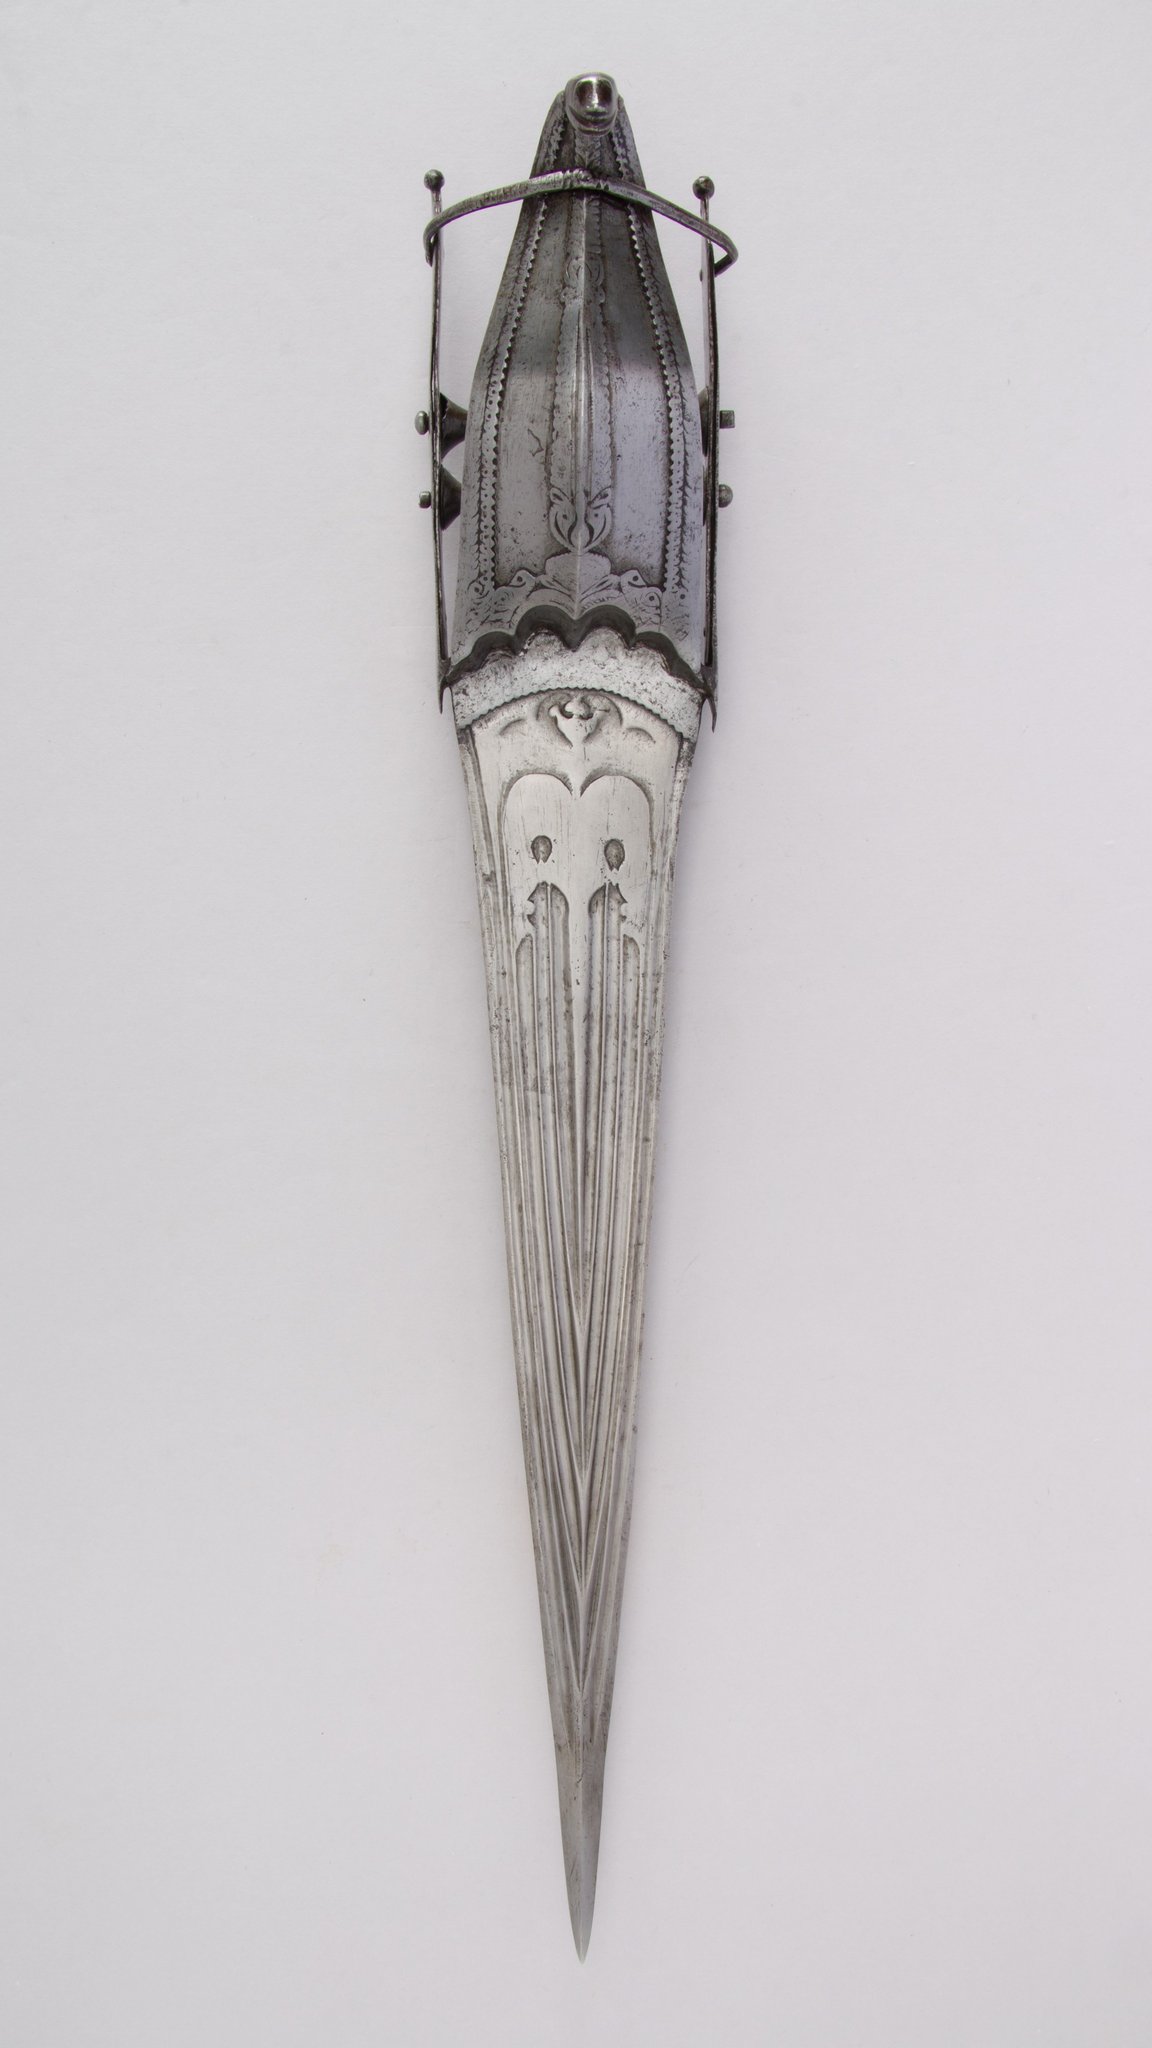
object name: dagger katar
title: Dagger (Katar)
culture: south indian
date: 1501-1600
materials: steel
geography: south india